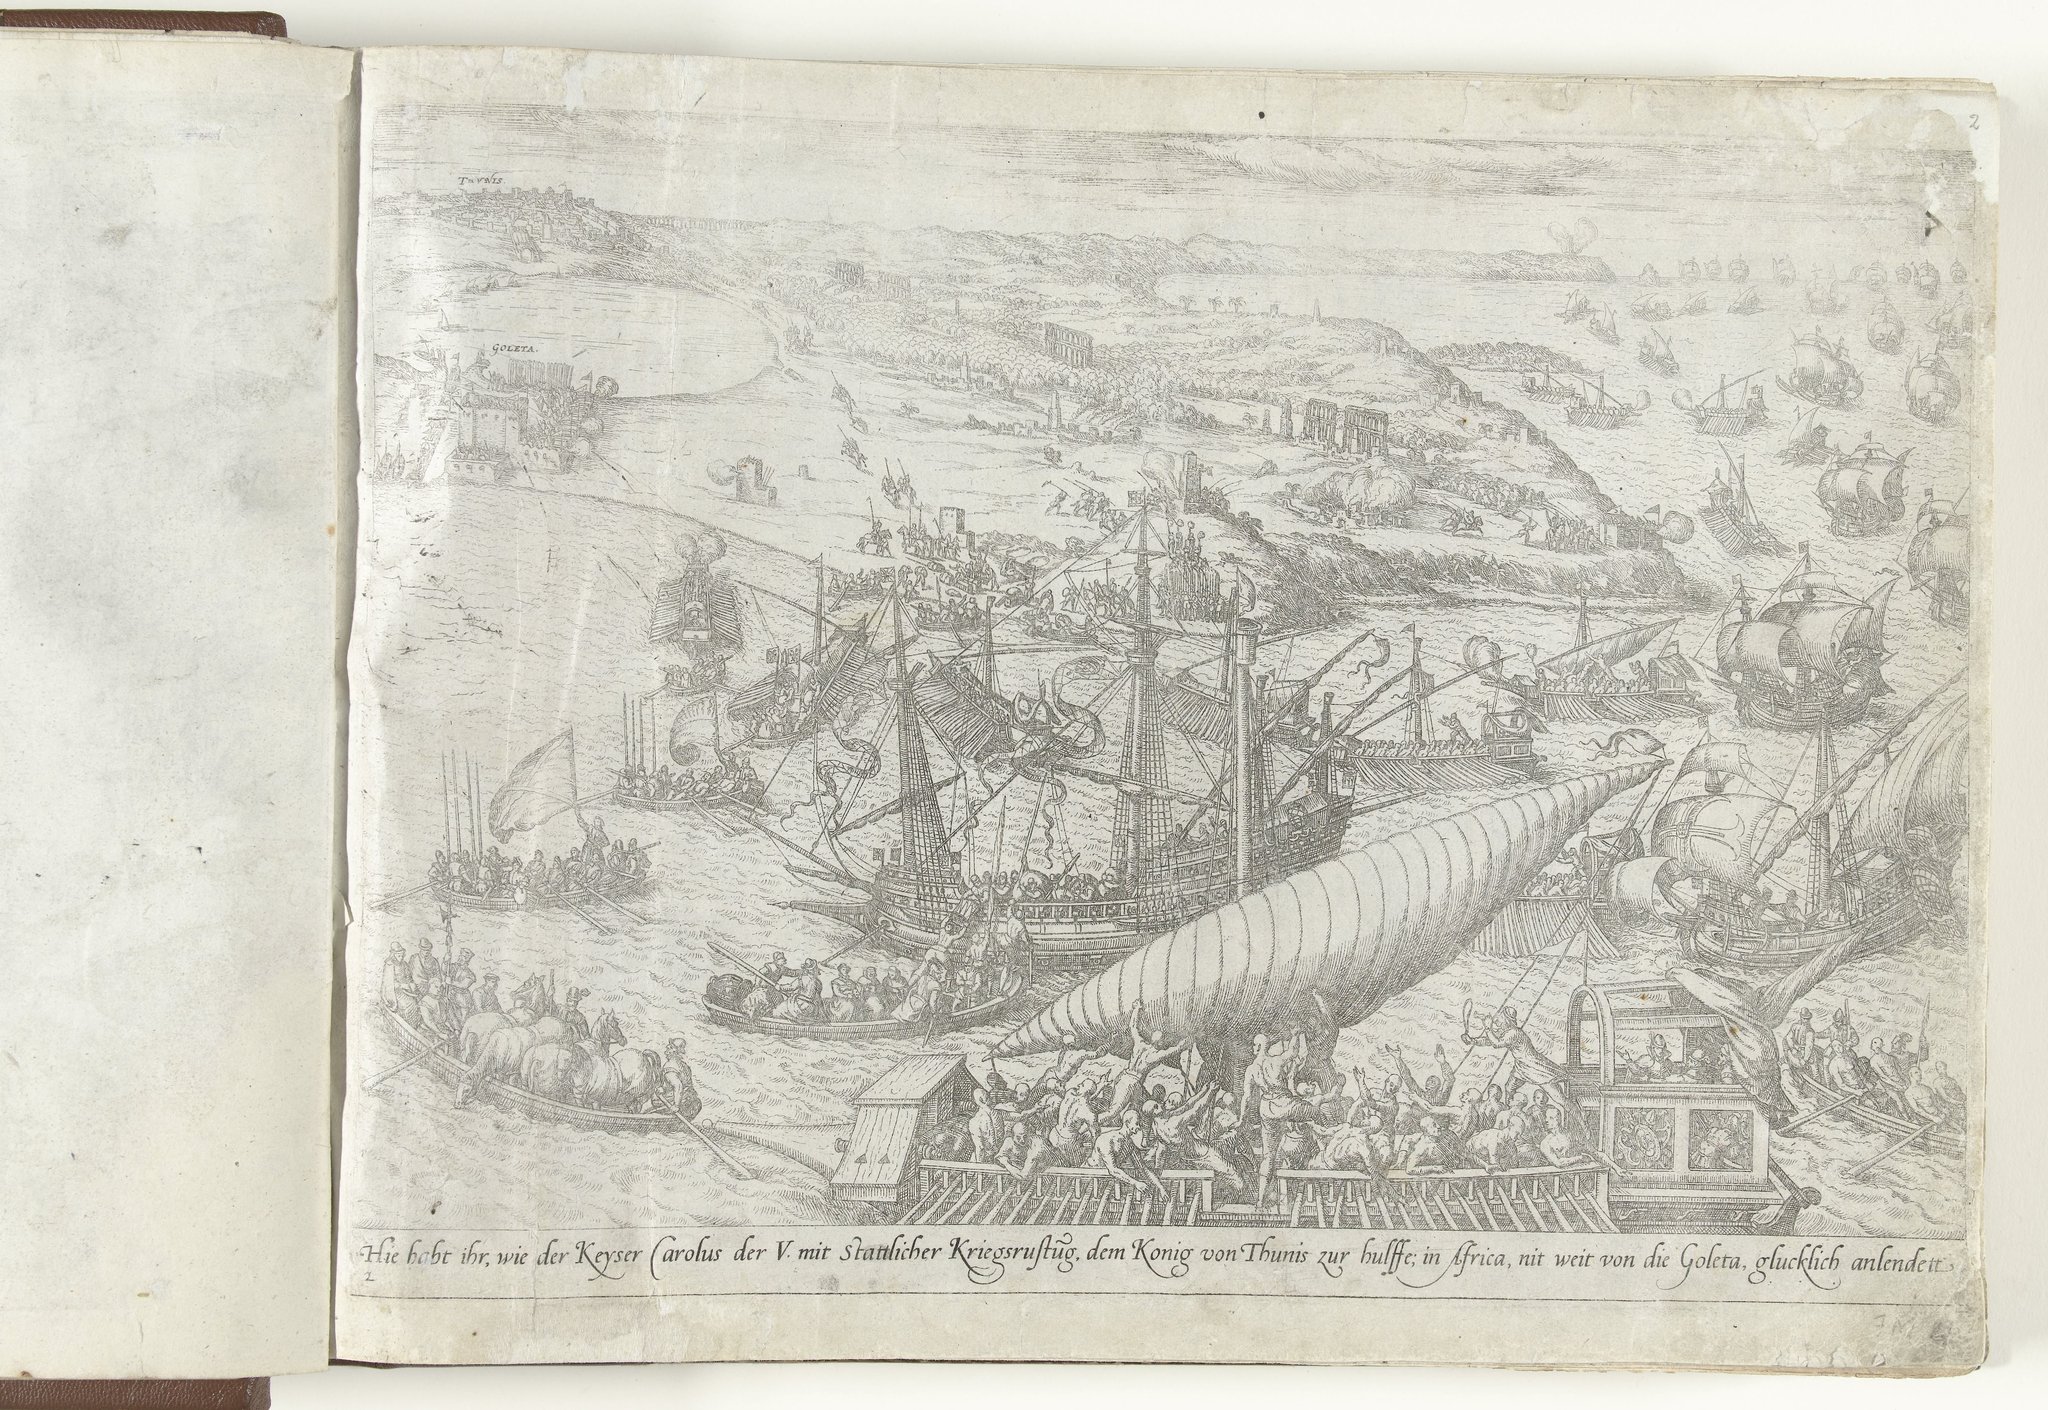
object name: album leaf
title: Kurtze erzeichniss wie Keyser Carolus der V. in Africa Dem Konig von Thunis, so von dem Barbarossen vertrieben, mit kriegsrustu[n]g zur hulffe komt, und was sich zugedragen, kont ihr in diese folgende figurn fein ordentlich nach ein ander sehen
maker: frans hogenberg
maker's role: print maker, publisher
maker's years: 1538-1590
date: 1574-1578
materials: paper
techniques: etching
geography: cologne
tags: ghent, charles v (holy roman emperor and king of spain), warfare; military affairs (+ landing, disembarkation of armed forces)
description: Aankomst van de keizerlijke vloot van galeien en zeilschepen bij Goleta, 1535. Links het fort Goleta, in de verte Tunis. Linksonder genummerd: 2.